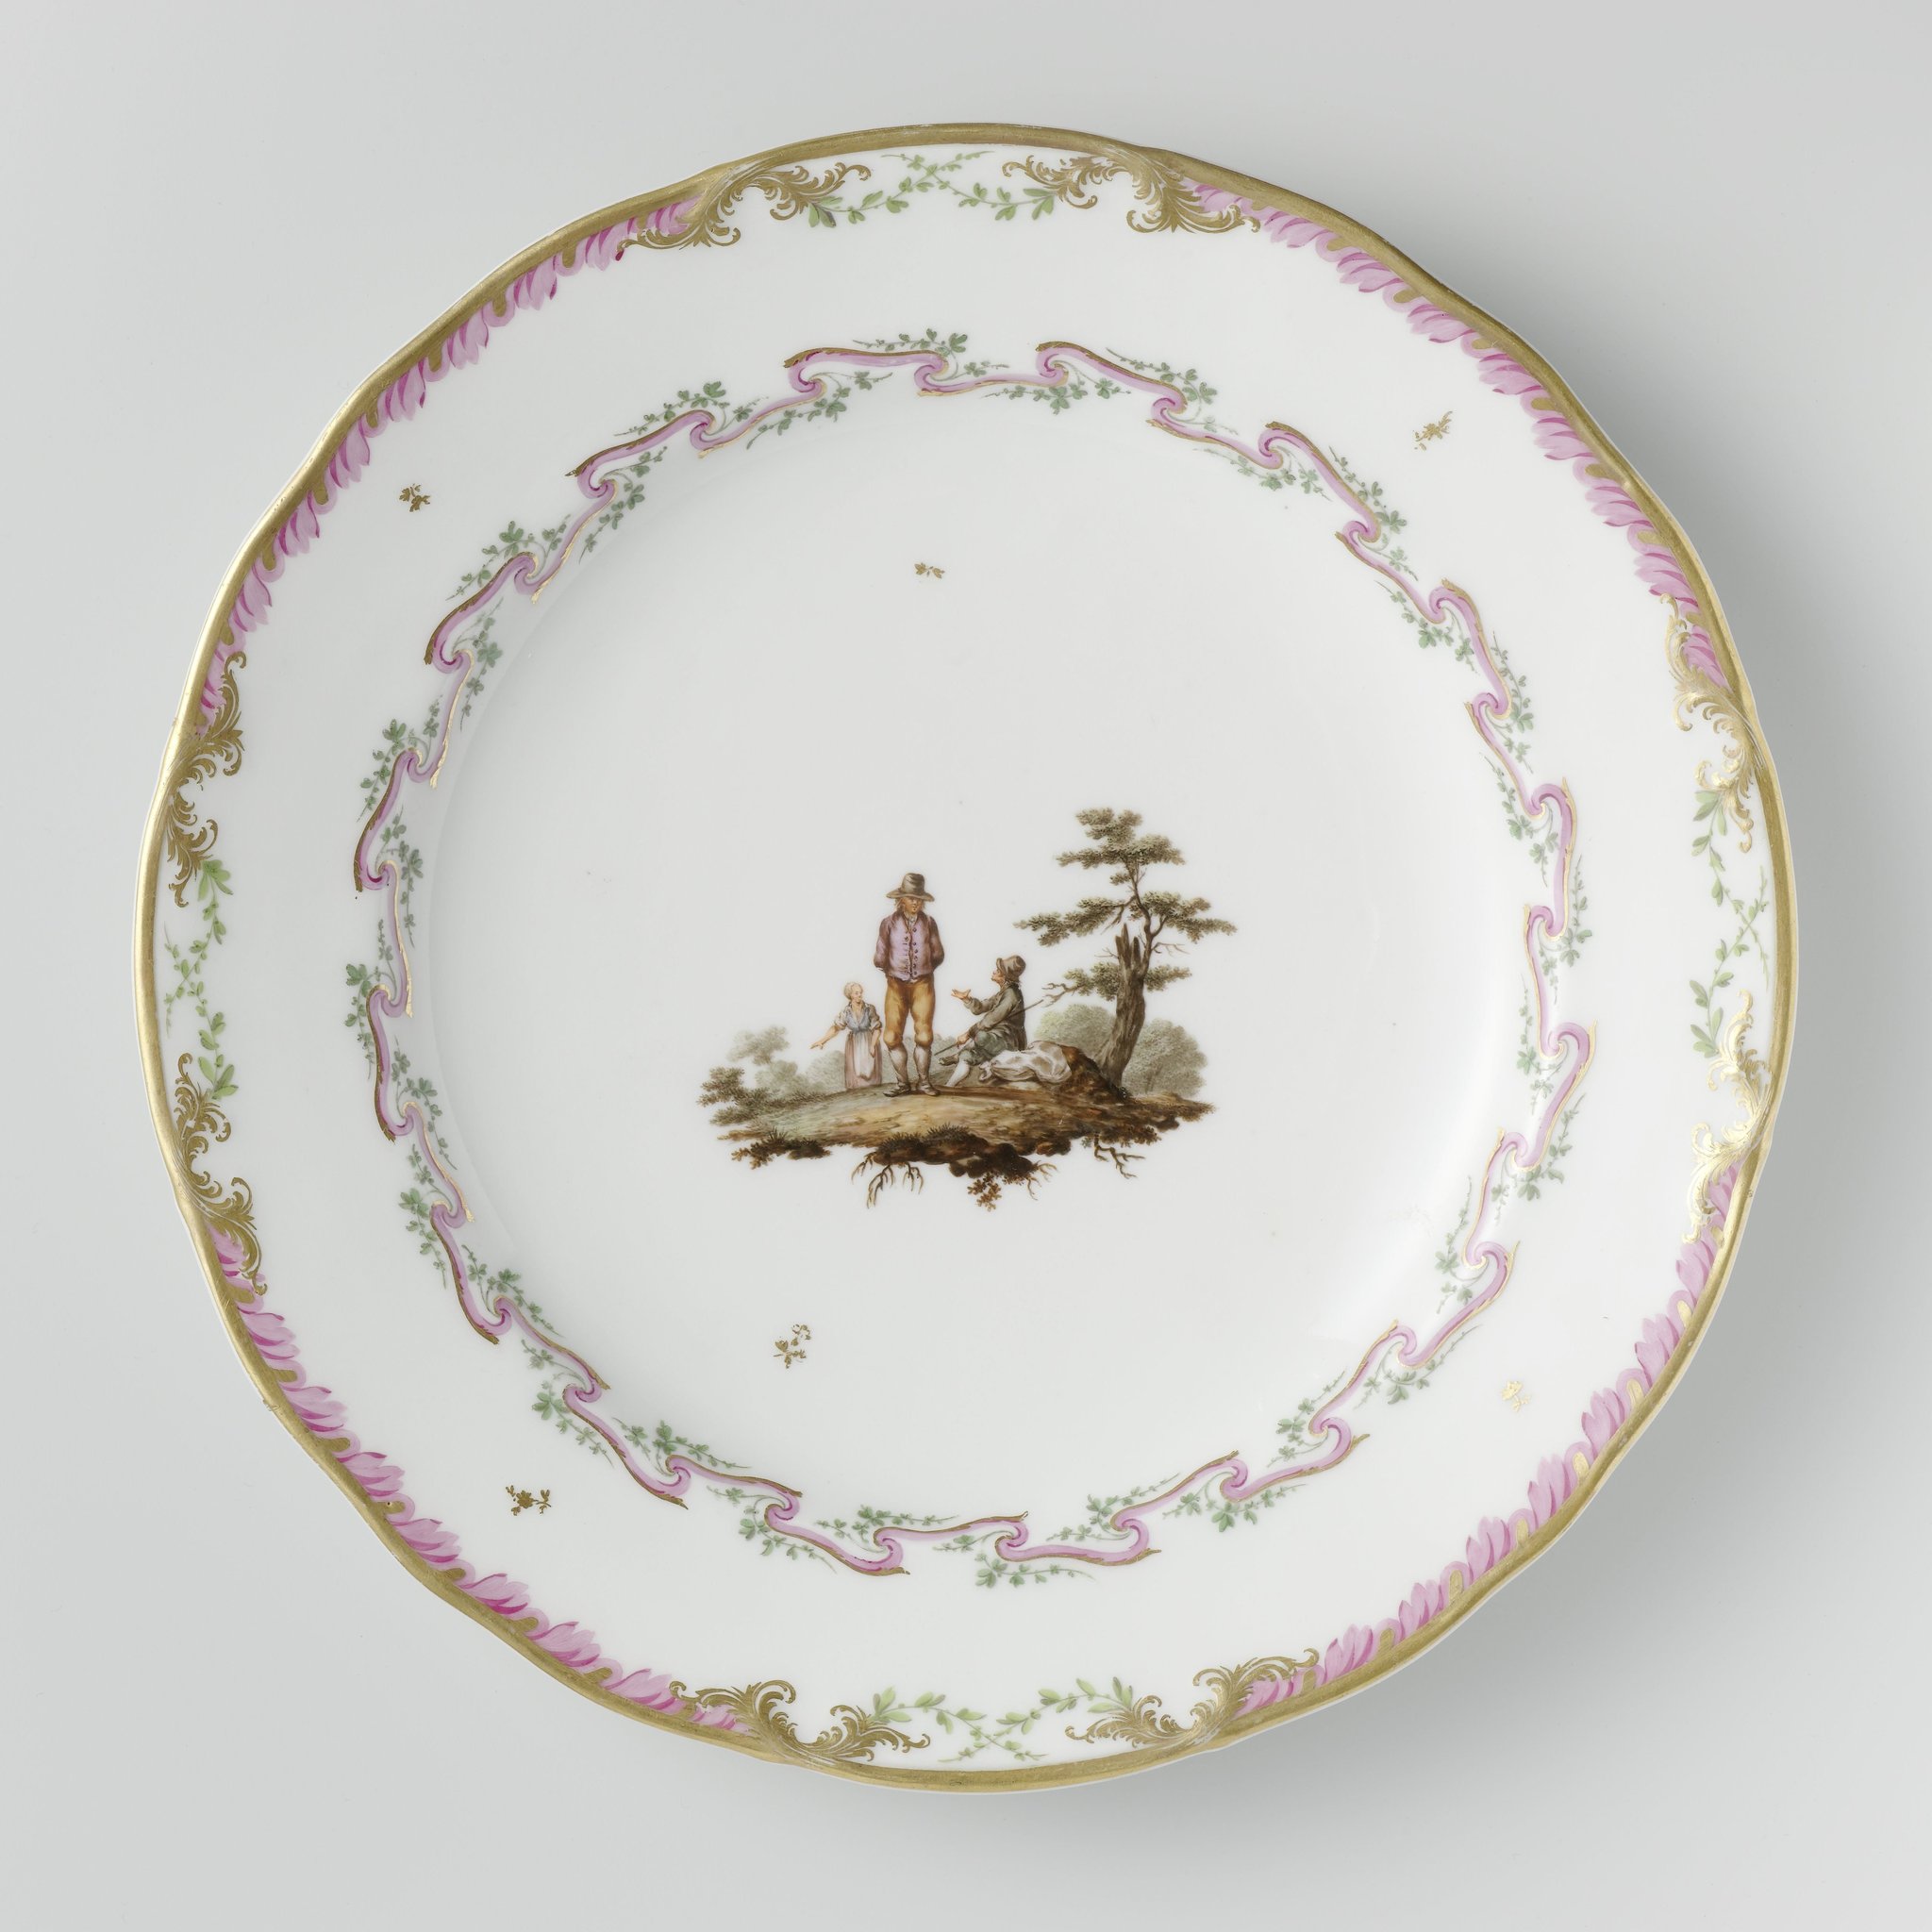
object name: plate dish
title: Plate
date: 1778-1782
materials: porcelain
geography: loosdrecht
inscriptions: mark: ‘9 B [?]’, collector's mark: ‘68 [of] 89’, mark: ‘* 8’, mark: ‘MOL *’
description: Manufactuur Oud-Loosdrecht Loosdrecht, c. 1778–1782 hard-paste porcelain